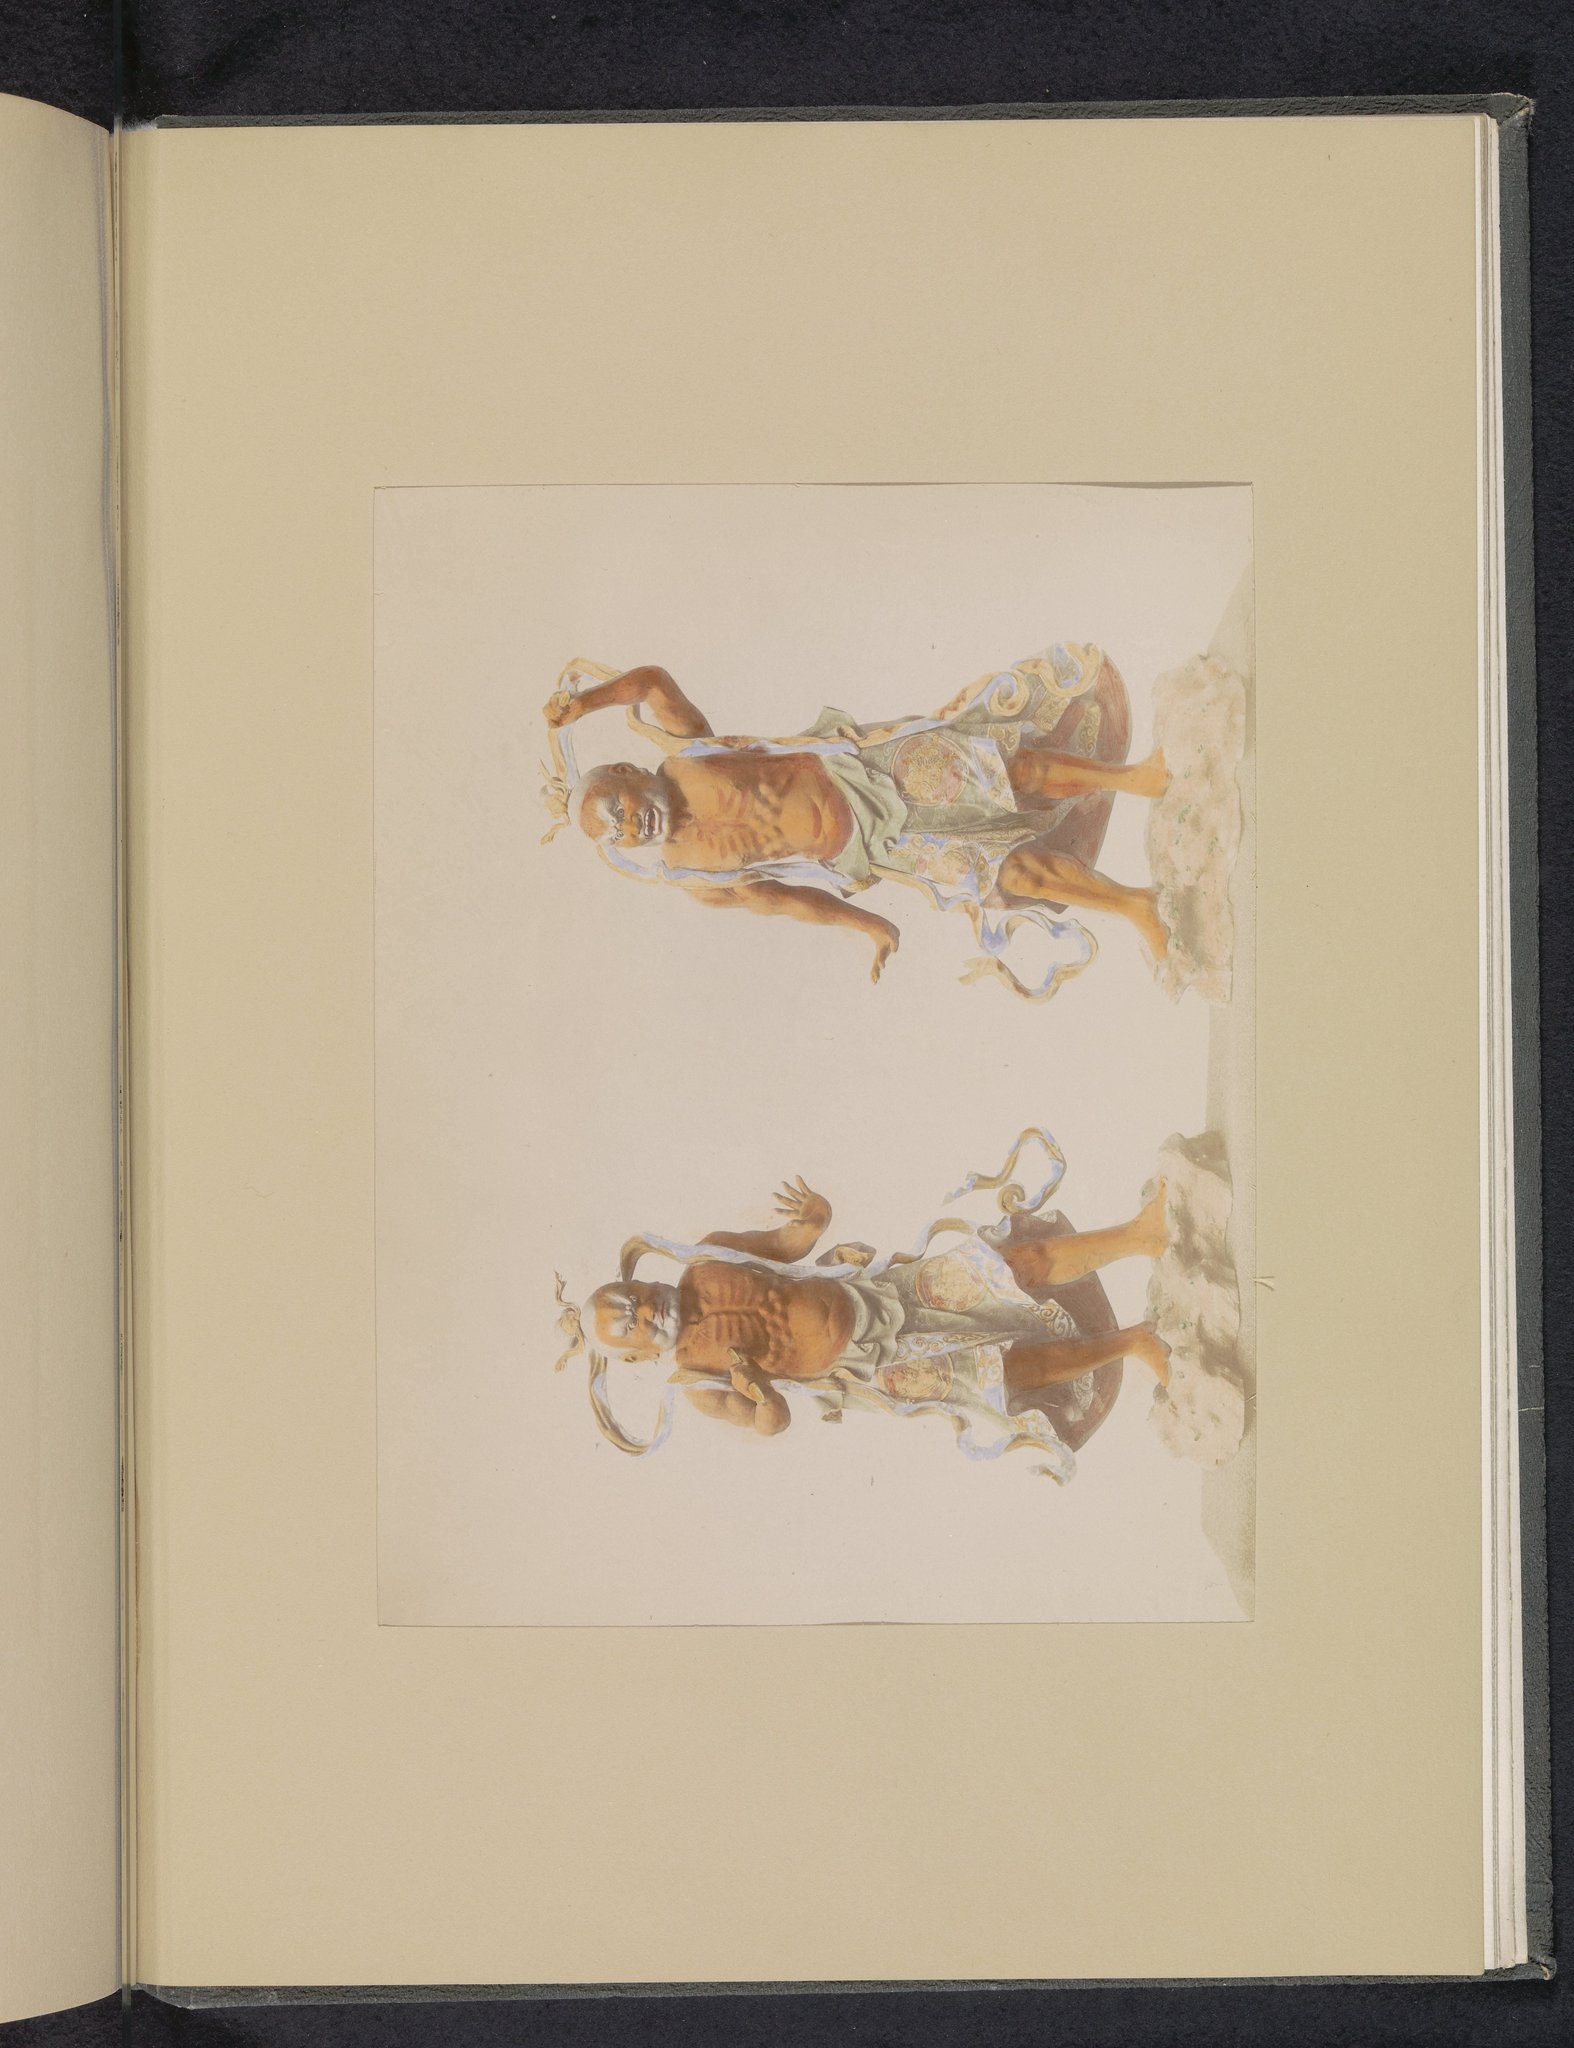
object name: photograph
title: Twee sculpturen van tempelbewakers (Niō)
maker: Anonymous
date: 1887-1897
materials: photographic support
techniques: albumen print, hand coloring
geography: japan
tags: hinduism, buddhism, jainism, sculpture, guard duty, keeping sentry